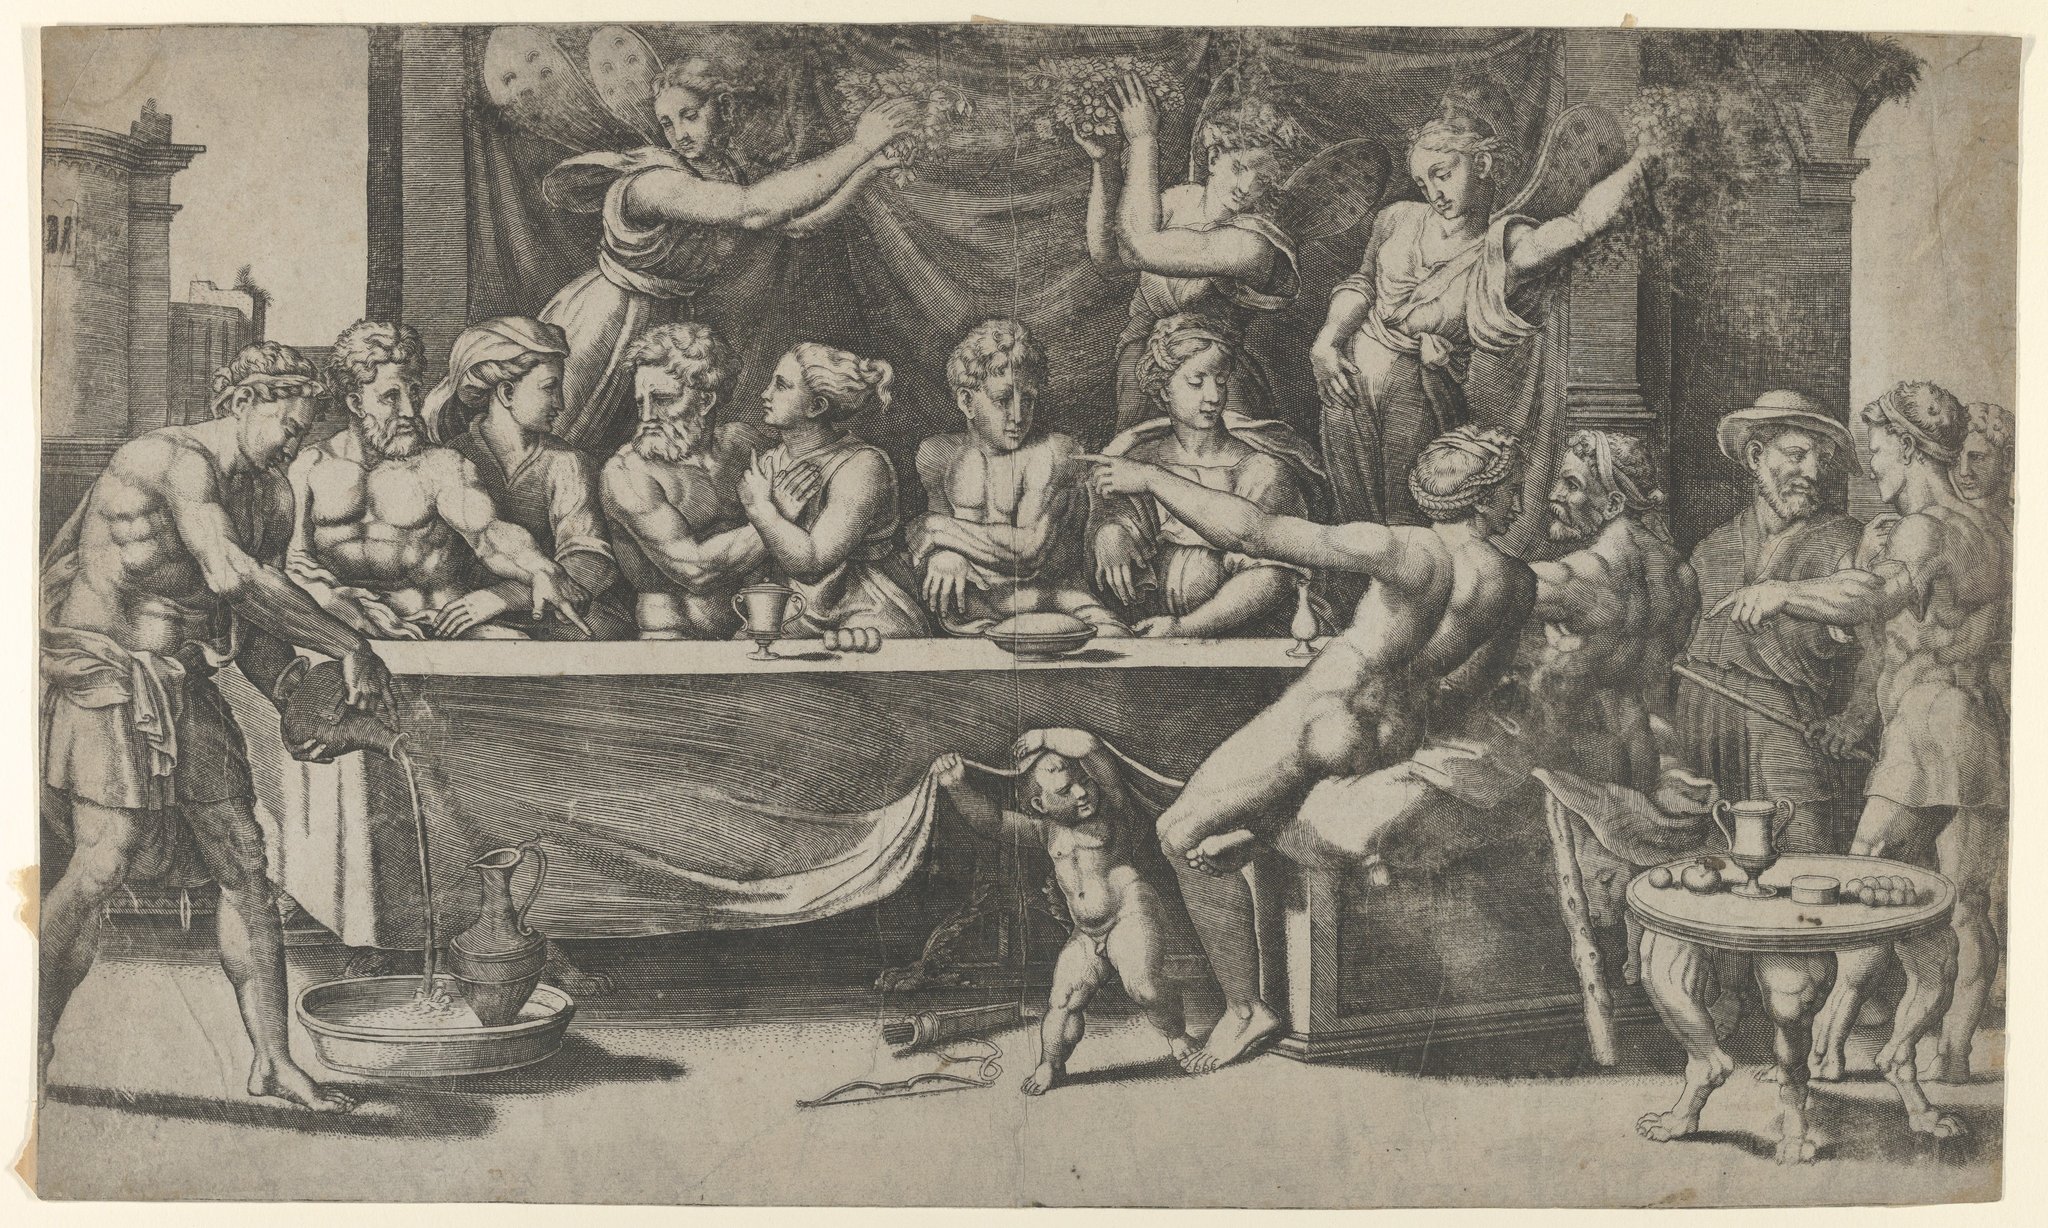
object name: print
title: The Olympian gods at the marriage feast of Cupid and Psyche, after Raphael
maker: master of the die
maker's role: artist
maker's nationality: italian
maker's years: 1525-1560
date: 1530-1535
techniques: engraving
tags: cupid,psyche